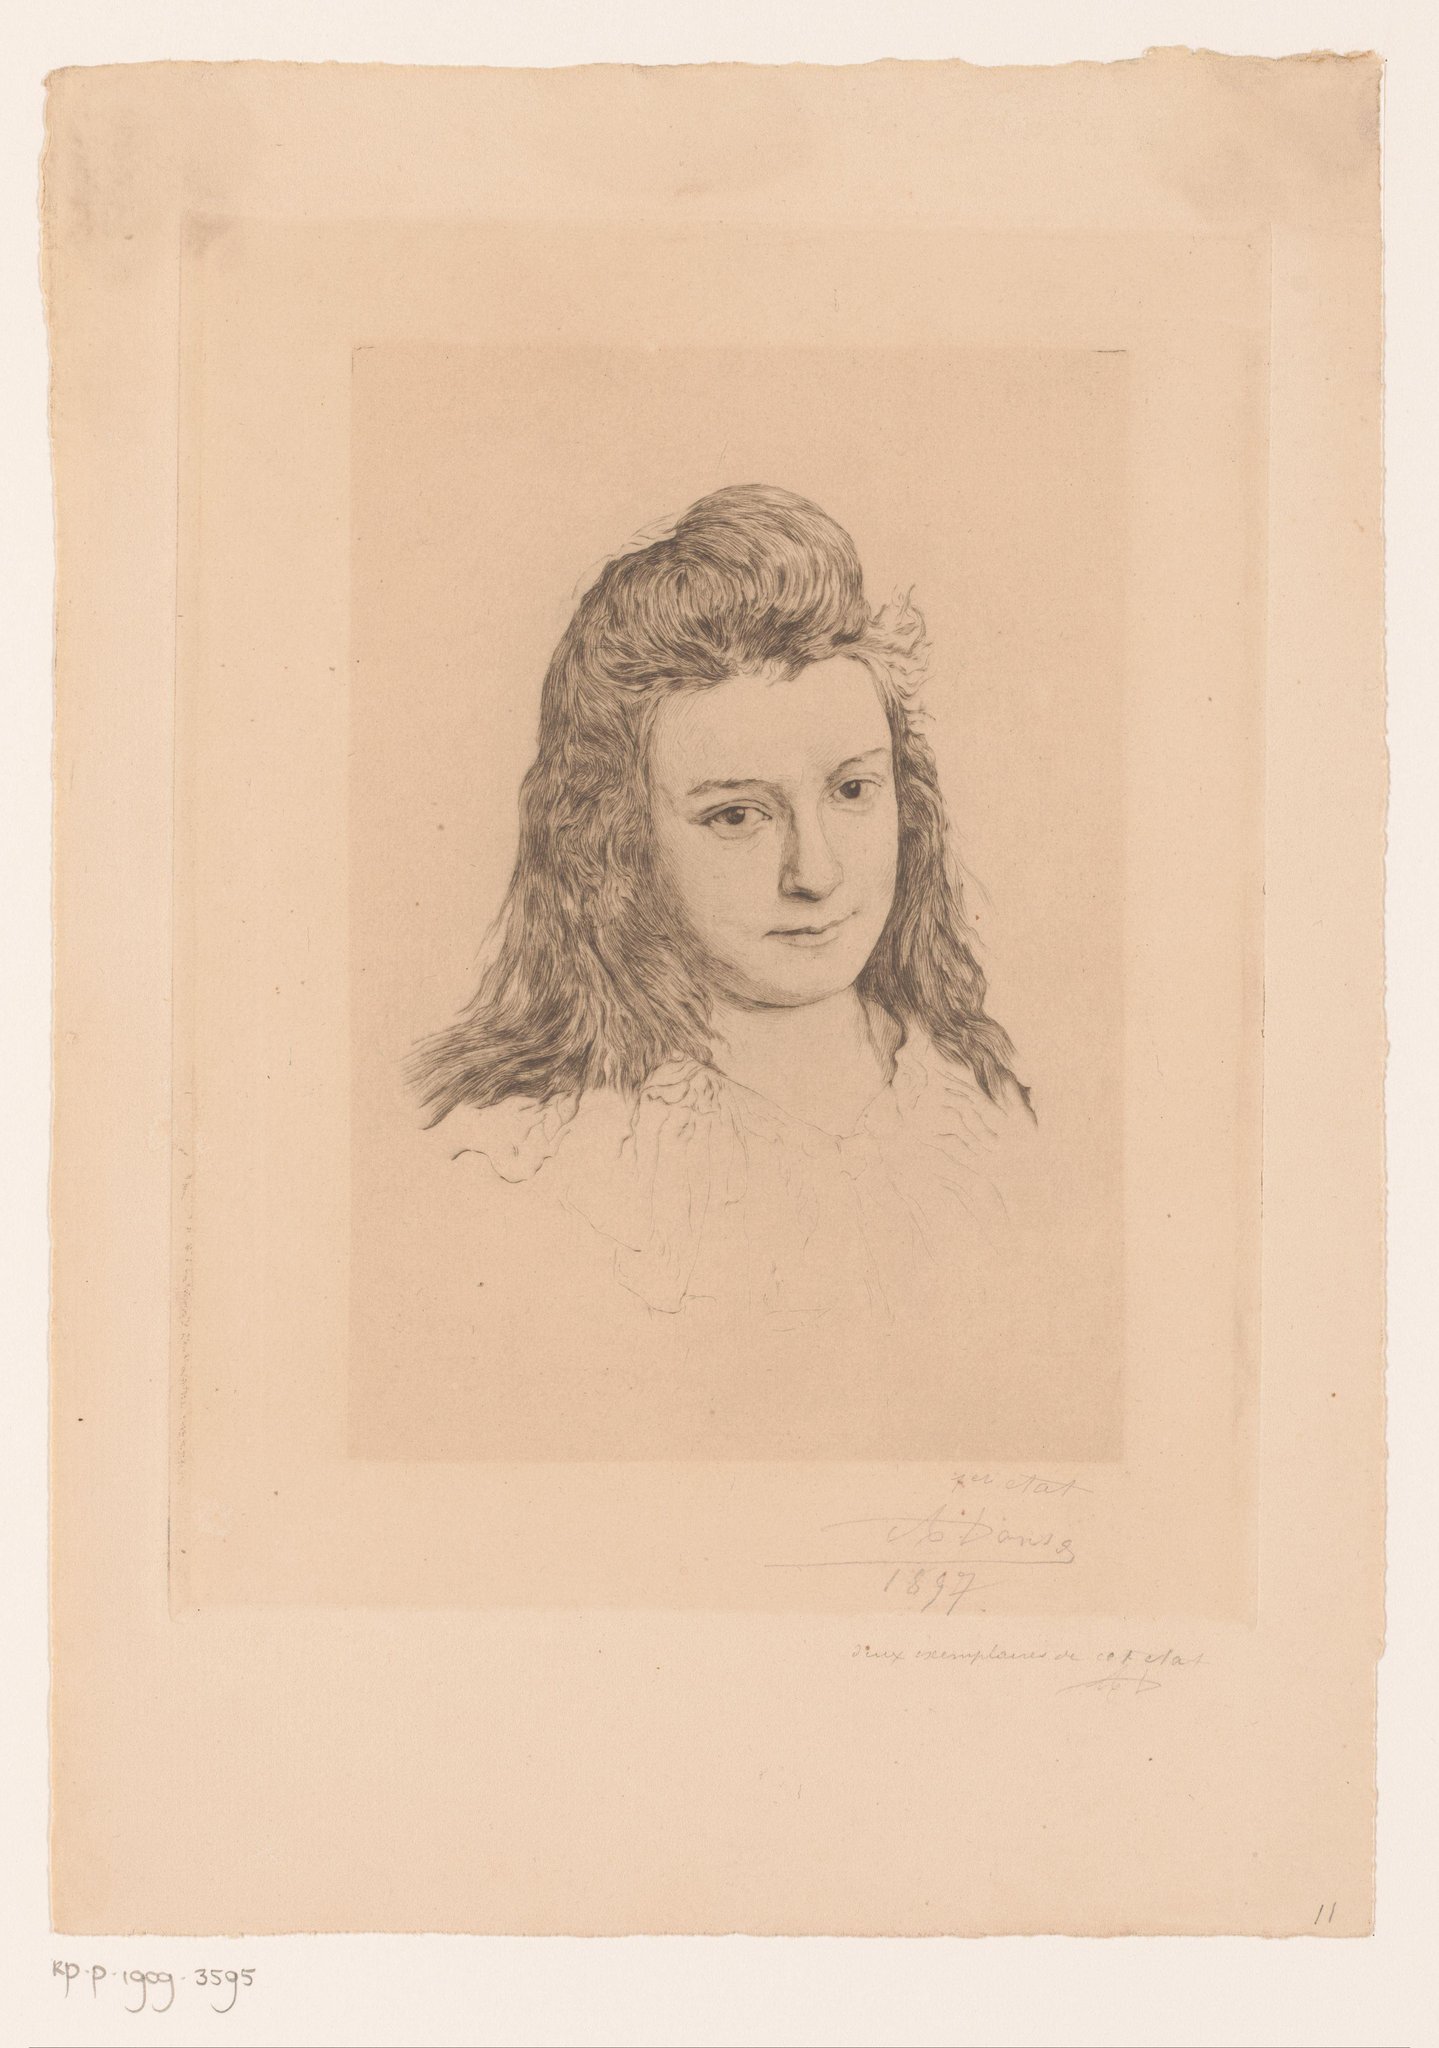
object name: print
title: Portret van de dochter van Victor-Charles Mahillon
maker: auguste danse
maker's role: print maker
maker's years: 1829-1929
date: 1897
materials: paper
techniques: drypoint, etching, intaglio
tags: historical person (with name) - bb - woman - historical person (with name) portrayed alone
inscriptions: annotation: ‘1er etat; deux exemplaires de cet etat’, collector's mark: Lugt 2228, watermark: ‘Van Gelder Zonen’